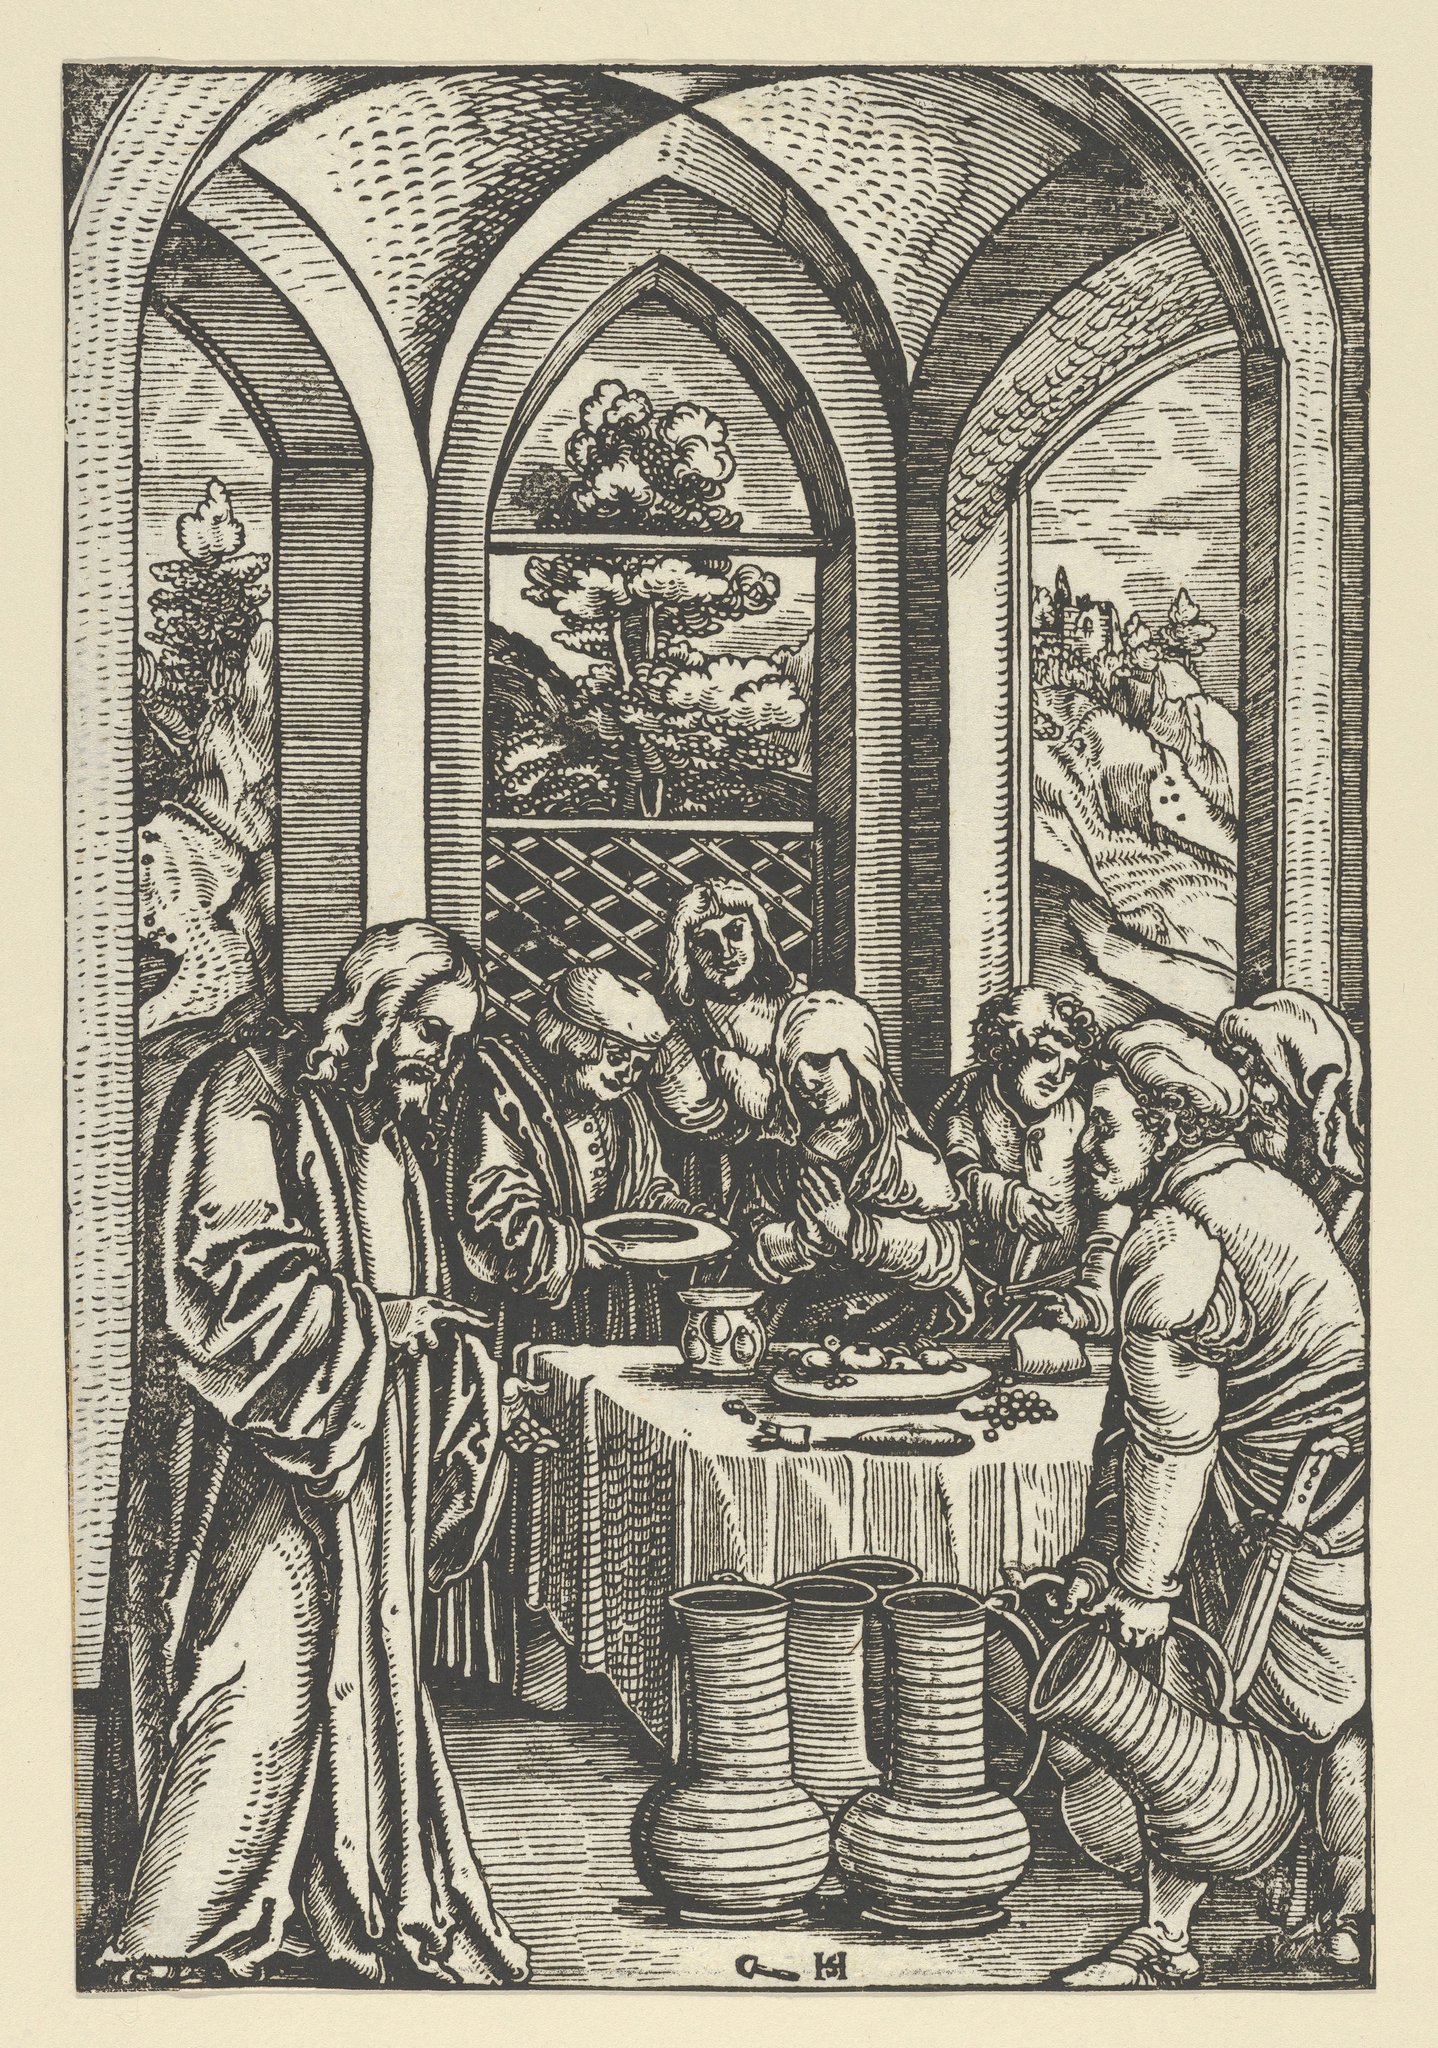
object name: print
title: The Wedding at Cana, from "The Life of Christ"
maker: hans schäufelein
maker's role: artist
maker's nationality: german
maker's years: 1480-1540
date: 1511-1512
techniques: woodcut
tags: men,women,christ